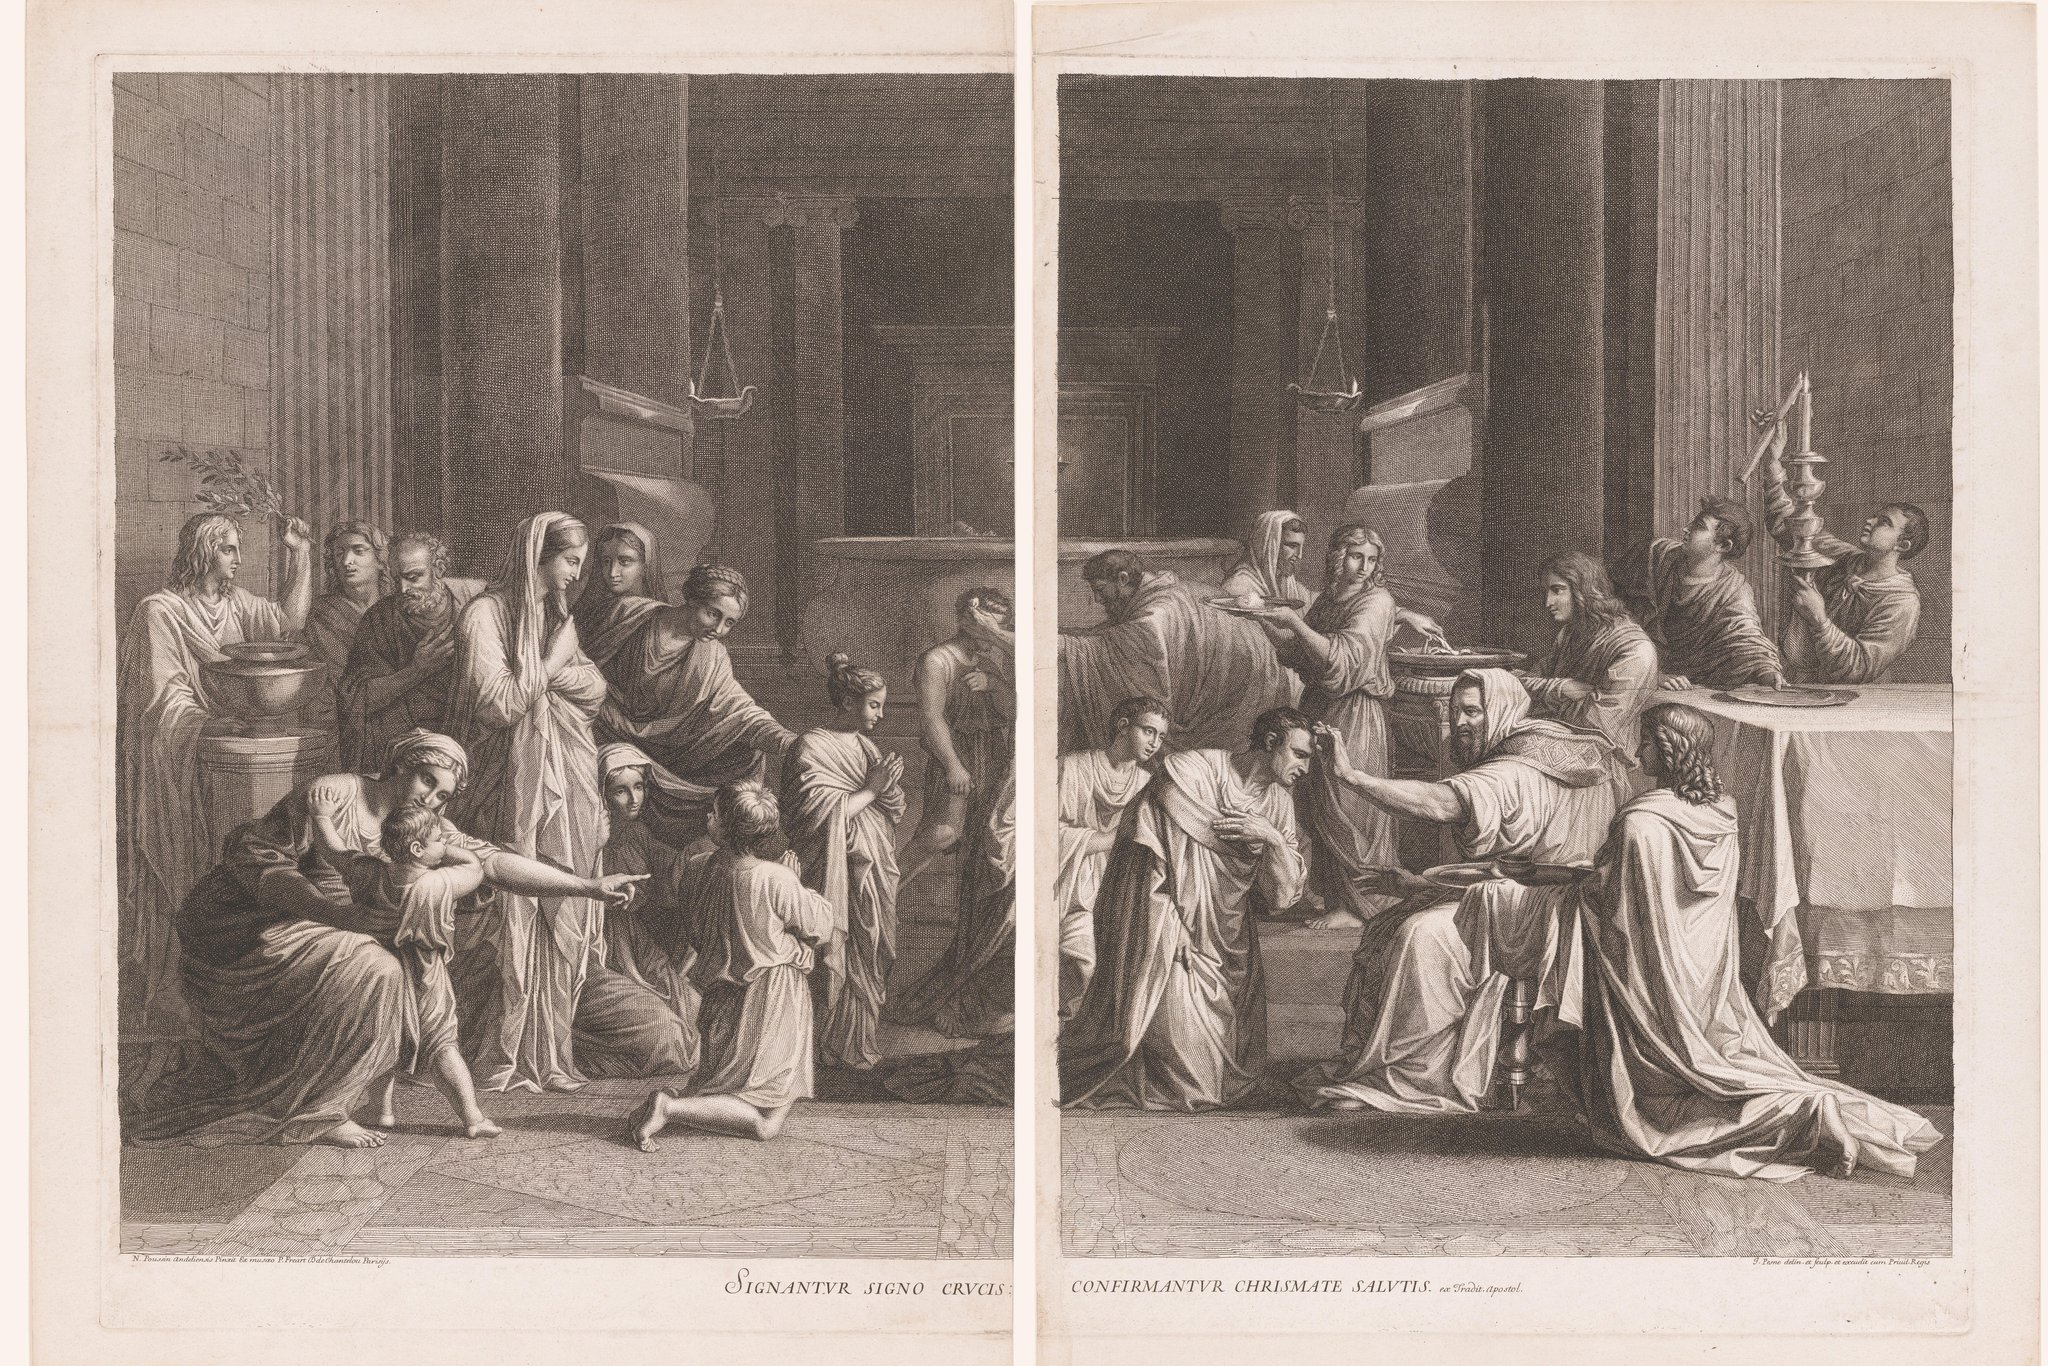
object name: print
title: Zeven sacramenten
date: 1633-1700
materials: paper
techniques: etching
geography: france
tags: confirmation ~ the second of the seven sacraments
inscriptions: collector's mark: Lugt 240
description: Prent maakt deel uit van een ongenummerde serie van zeven prenten. Dit object is omwille van een betere presentatie virtueel samengevoegd, maar bestaat fysiek uit losse onderdelen.